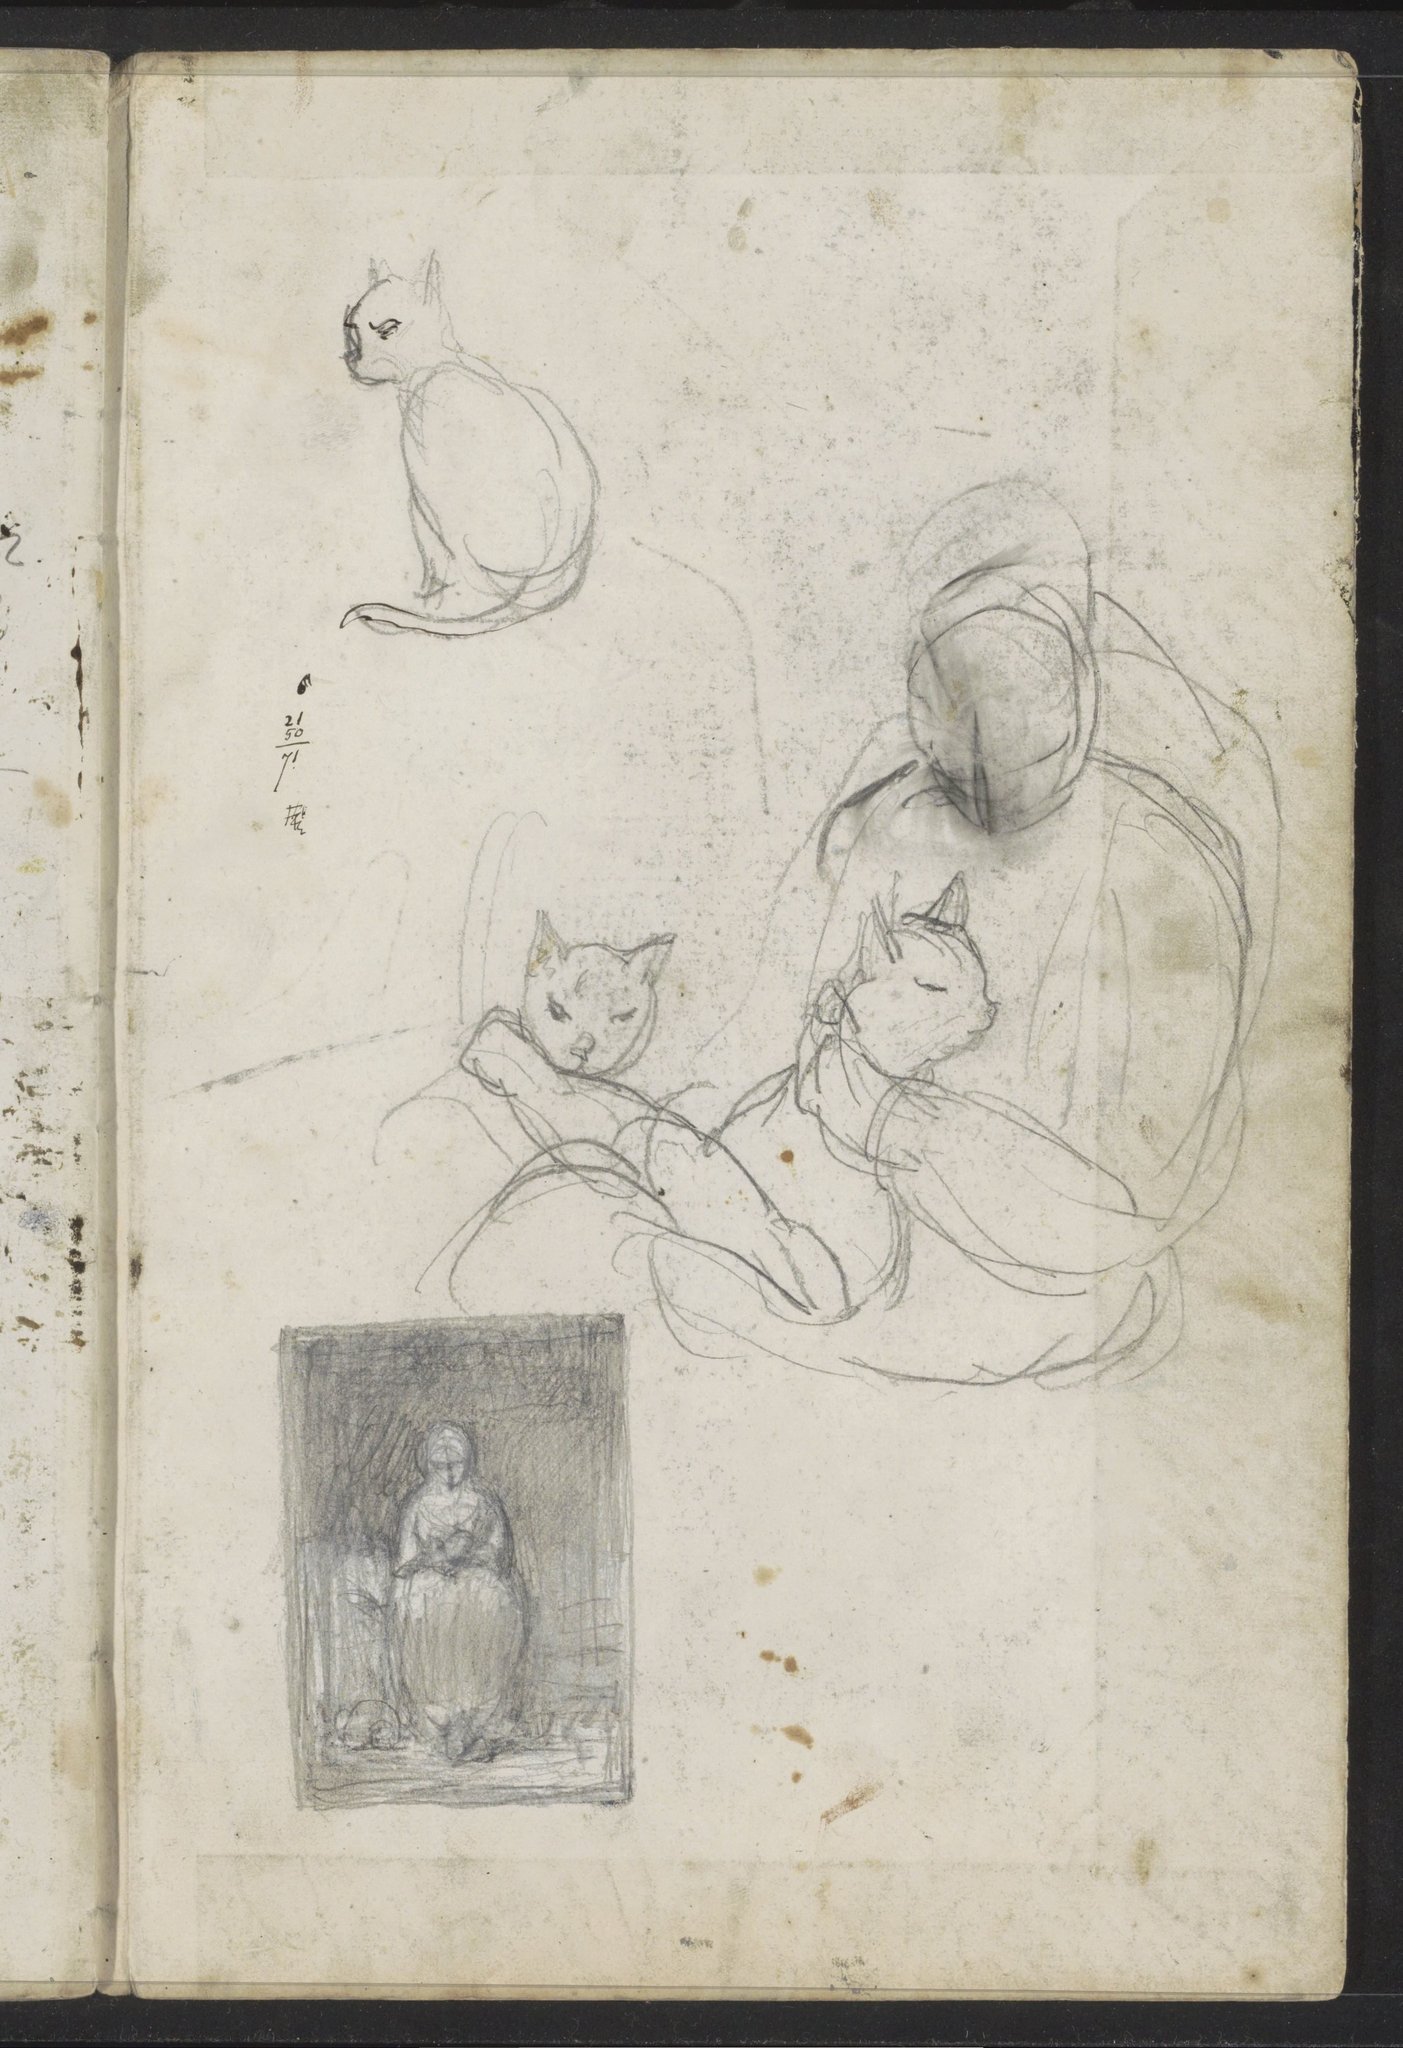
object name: sketchbook leaf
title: Katten, een handwerkende vrouw en een figuur met een kat op schoot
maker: jozef israëls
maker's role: draughtsman, painter, print maker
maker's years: 1824-1911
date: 1855-1859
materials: paint, paper, pencil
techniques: brush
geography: zandvoort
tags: cat, home sewing; repair of clothes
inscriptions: annotation: ‘[...]’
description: Achterste schutblad uit een schetsboek met 22 bladen.